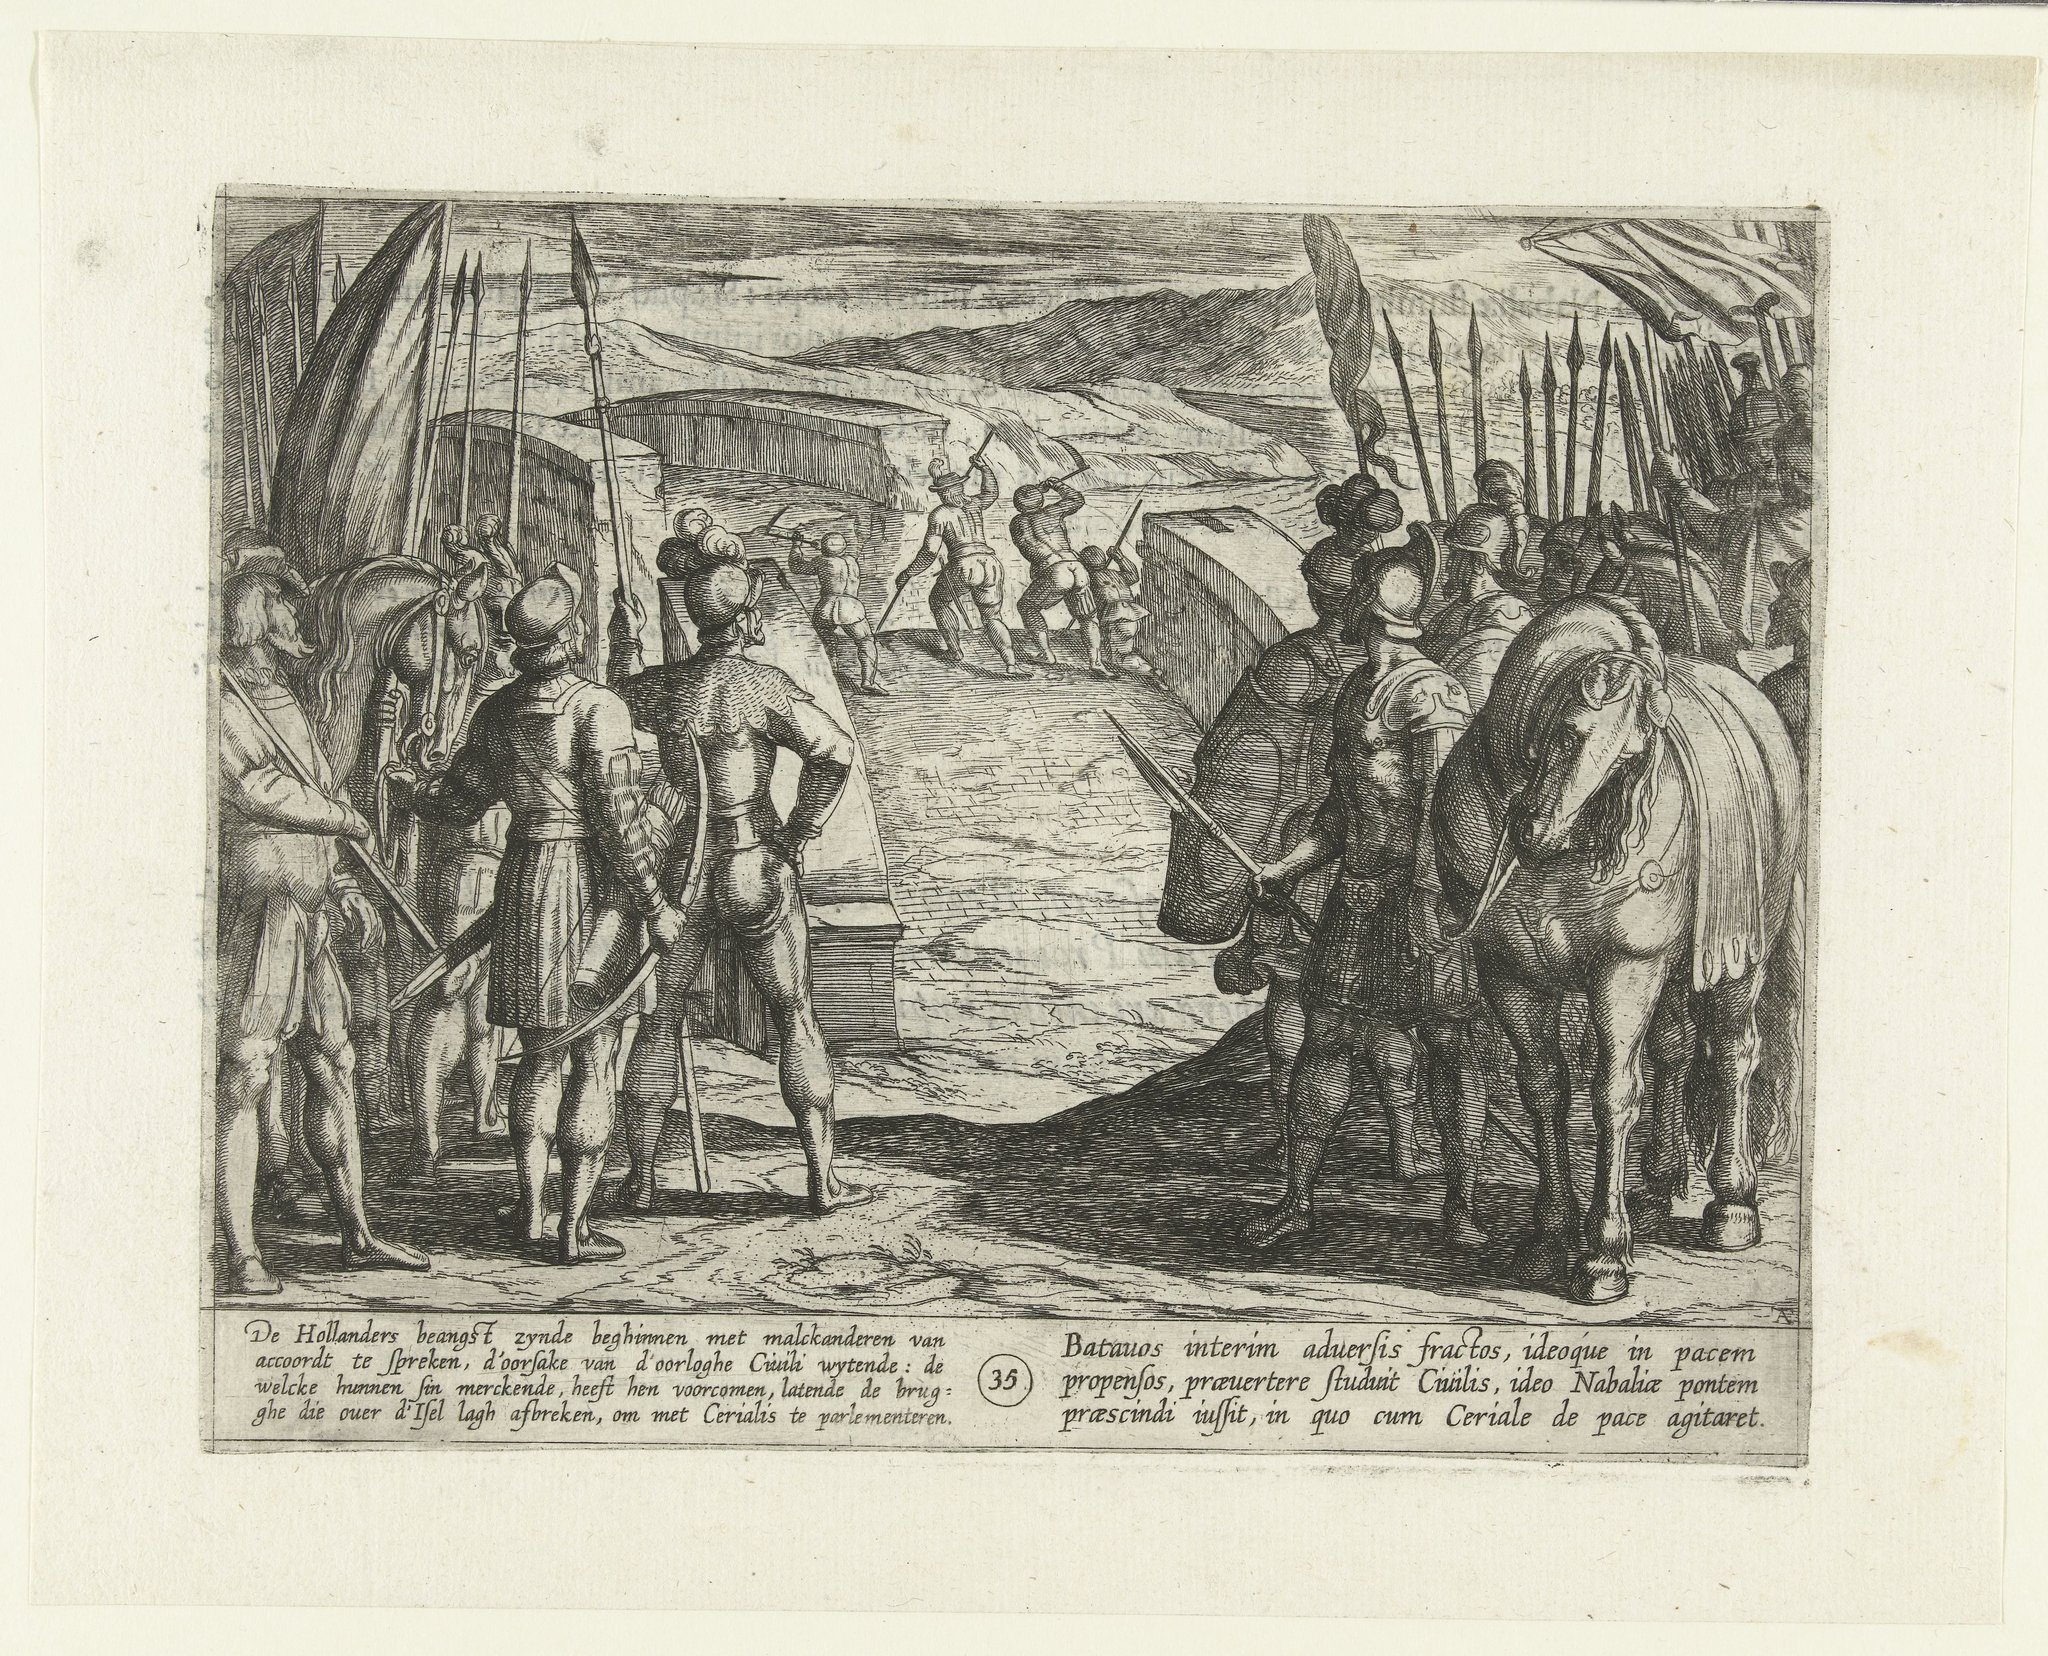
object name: print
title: Bataven breken de brug over de IJssel af, 69-70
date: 1612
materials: paper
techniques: etching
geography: italy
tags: battle, fighting in general, extinct, 'historical' peoples (with name)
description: Bataven worden bang en breken de brug over de IJssel af om met Cerialis te kunnen onderhandelen. Prent nummer 35 in de serie prenten over de Bataafse Opstand: Batavorum cum Romanis bellum / à Corn. Tacito lib. IV & V. : Hist. olim descriptum, figuris nunc aeneis expressum, auctore Othone Vaenio Lugdunobatava = De Batavische oft oude Hollandtsche oorloghe teghen de Romeynen. Otto Vaenius, Antwerpen 1612. Onderaan twee verzen van vier regels in het Nederlands en in het Latijn. Op de achterzijde tekst in het Latijn.